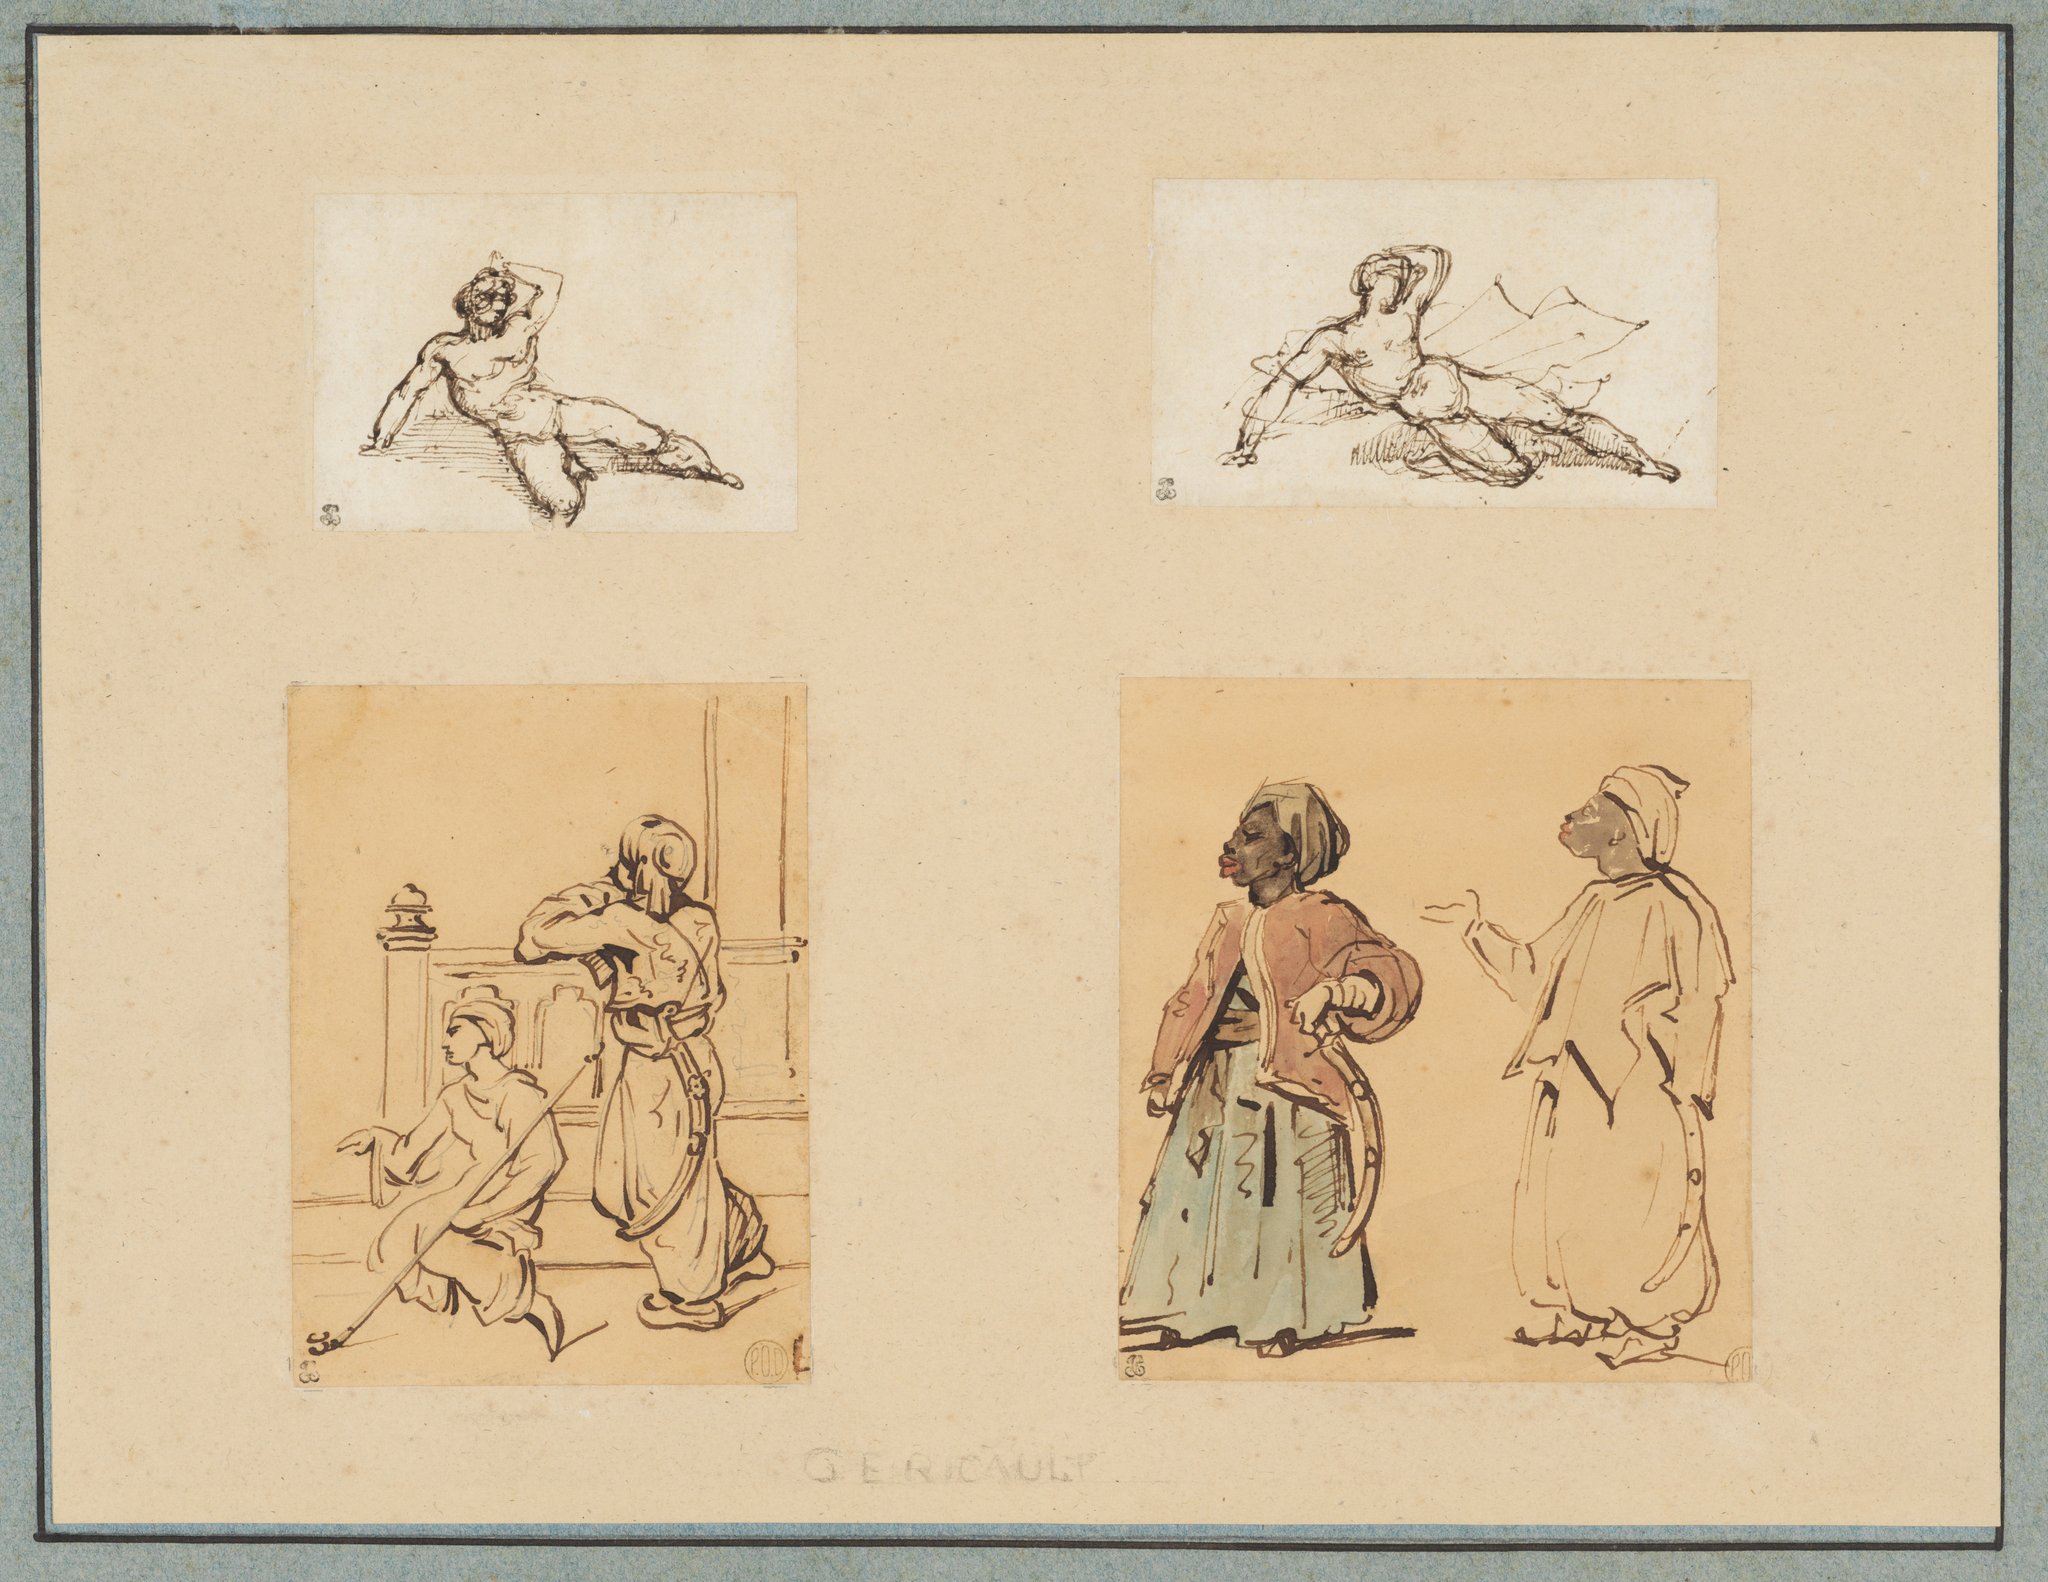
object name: drawing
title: Four drawings: Two Reclining Male Nudes and Two Studies of Ottoman Figures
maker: jean louis andré théodore géricault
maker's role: artist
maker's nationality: french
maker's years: 1791-1824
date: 1816-1823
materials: ink, watercolor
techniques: pen